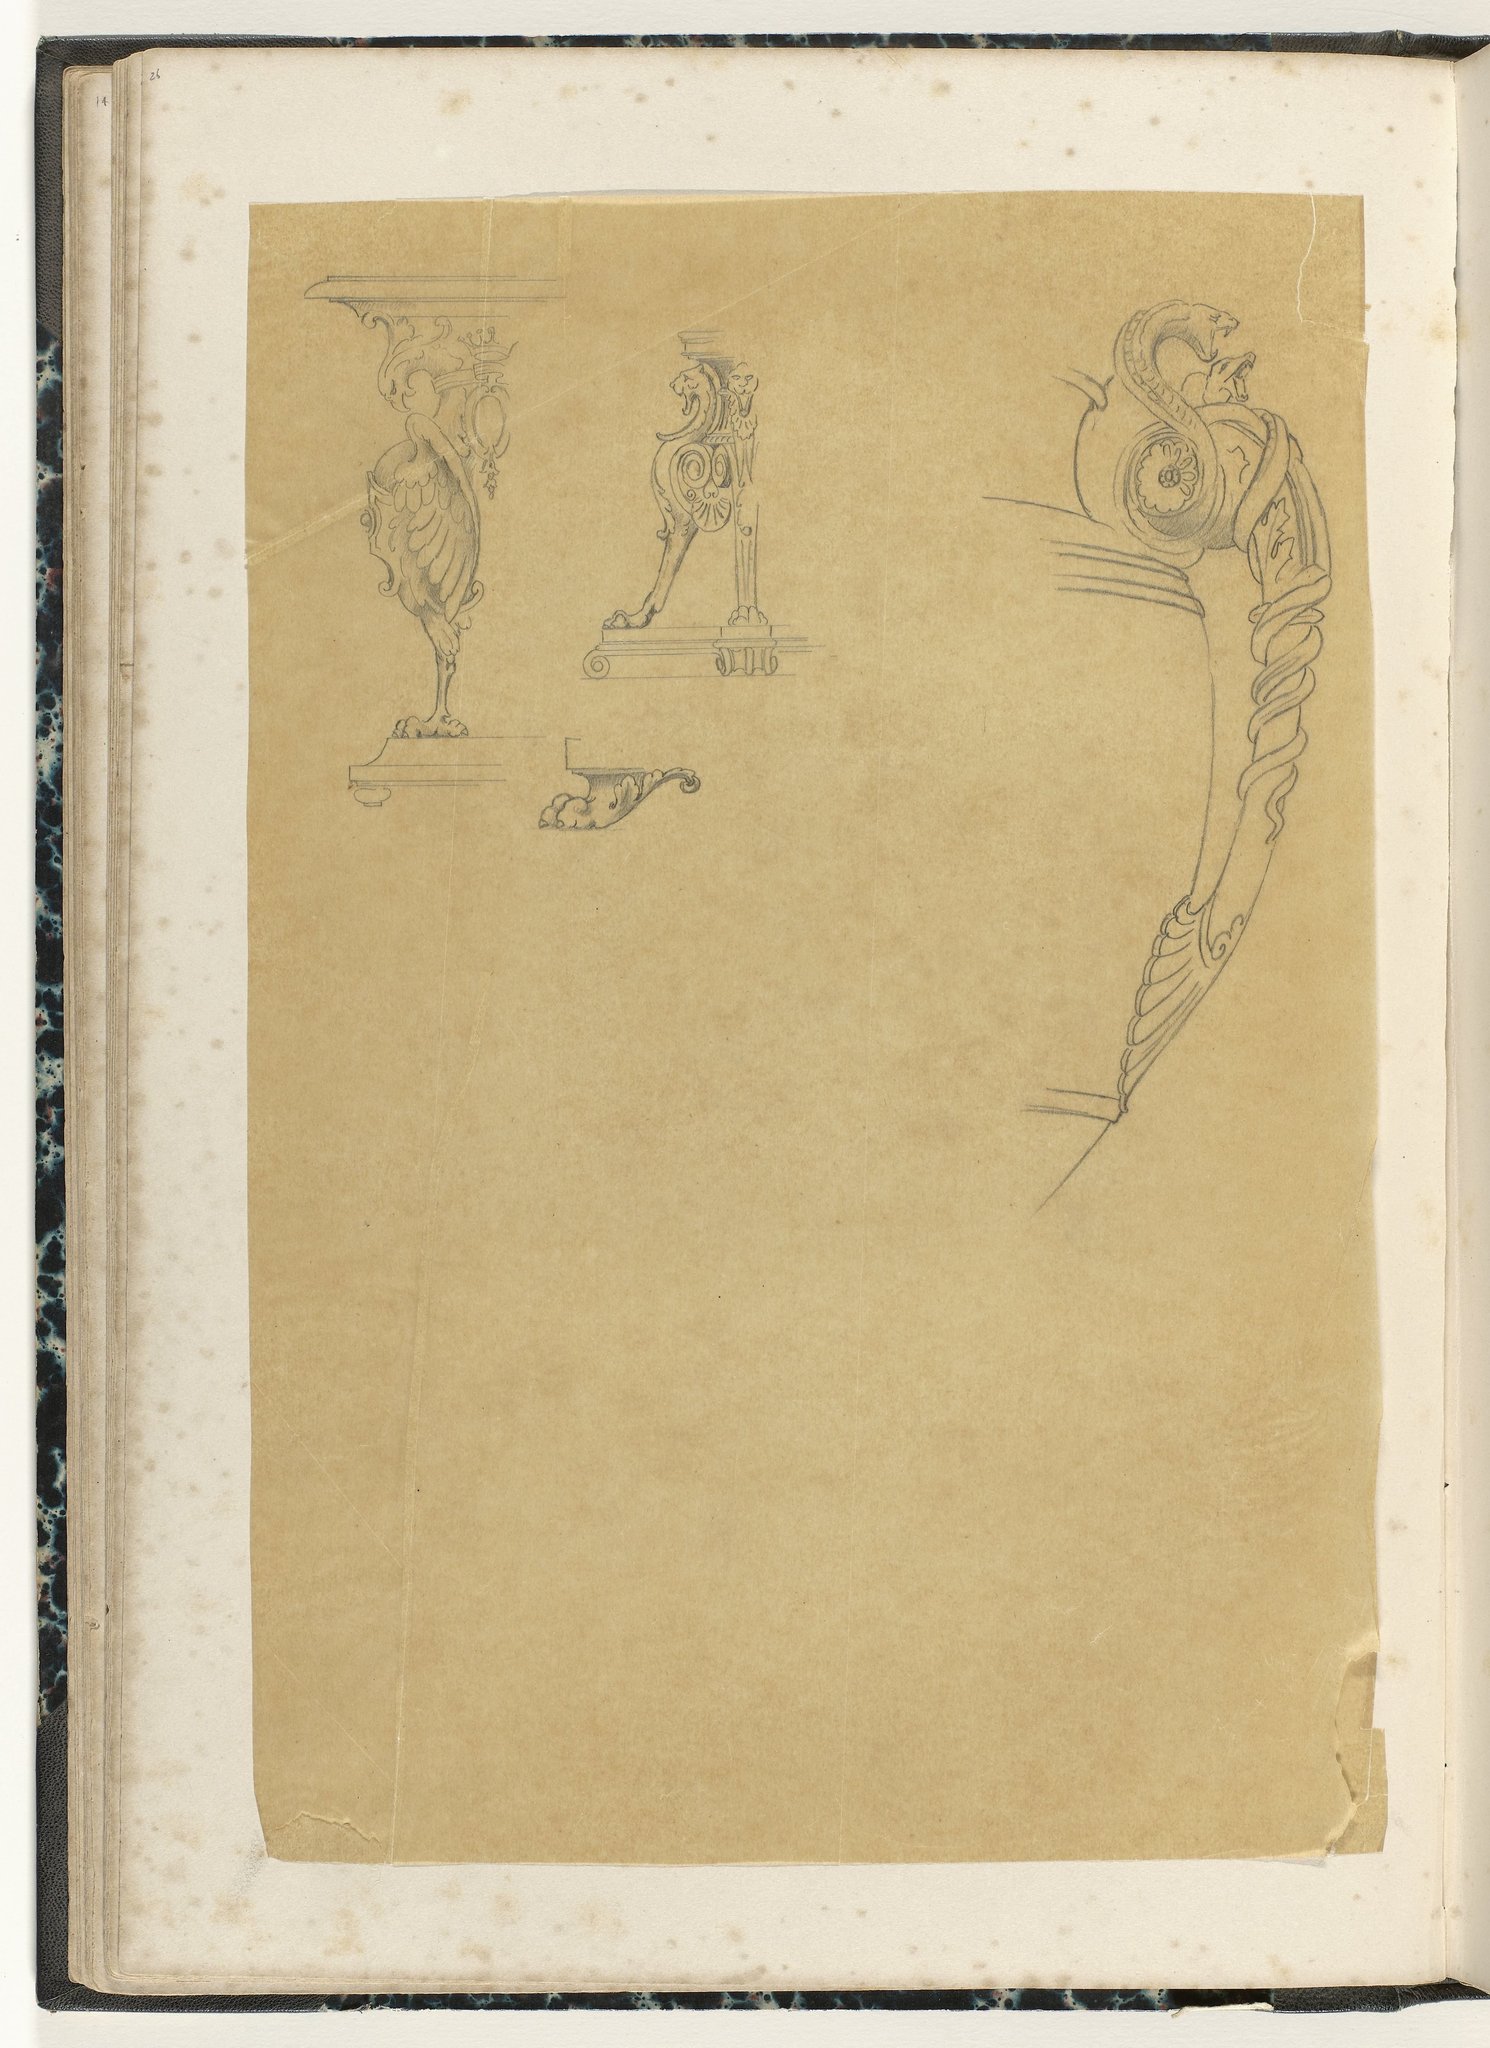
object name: drawing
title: Drie meubelpoten en handvat van vaas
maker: Anonymous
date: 1866-1900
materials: paper, pencil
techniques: drawing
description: De tafelpoot links heeft de vorm van een roofvogel.